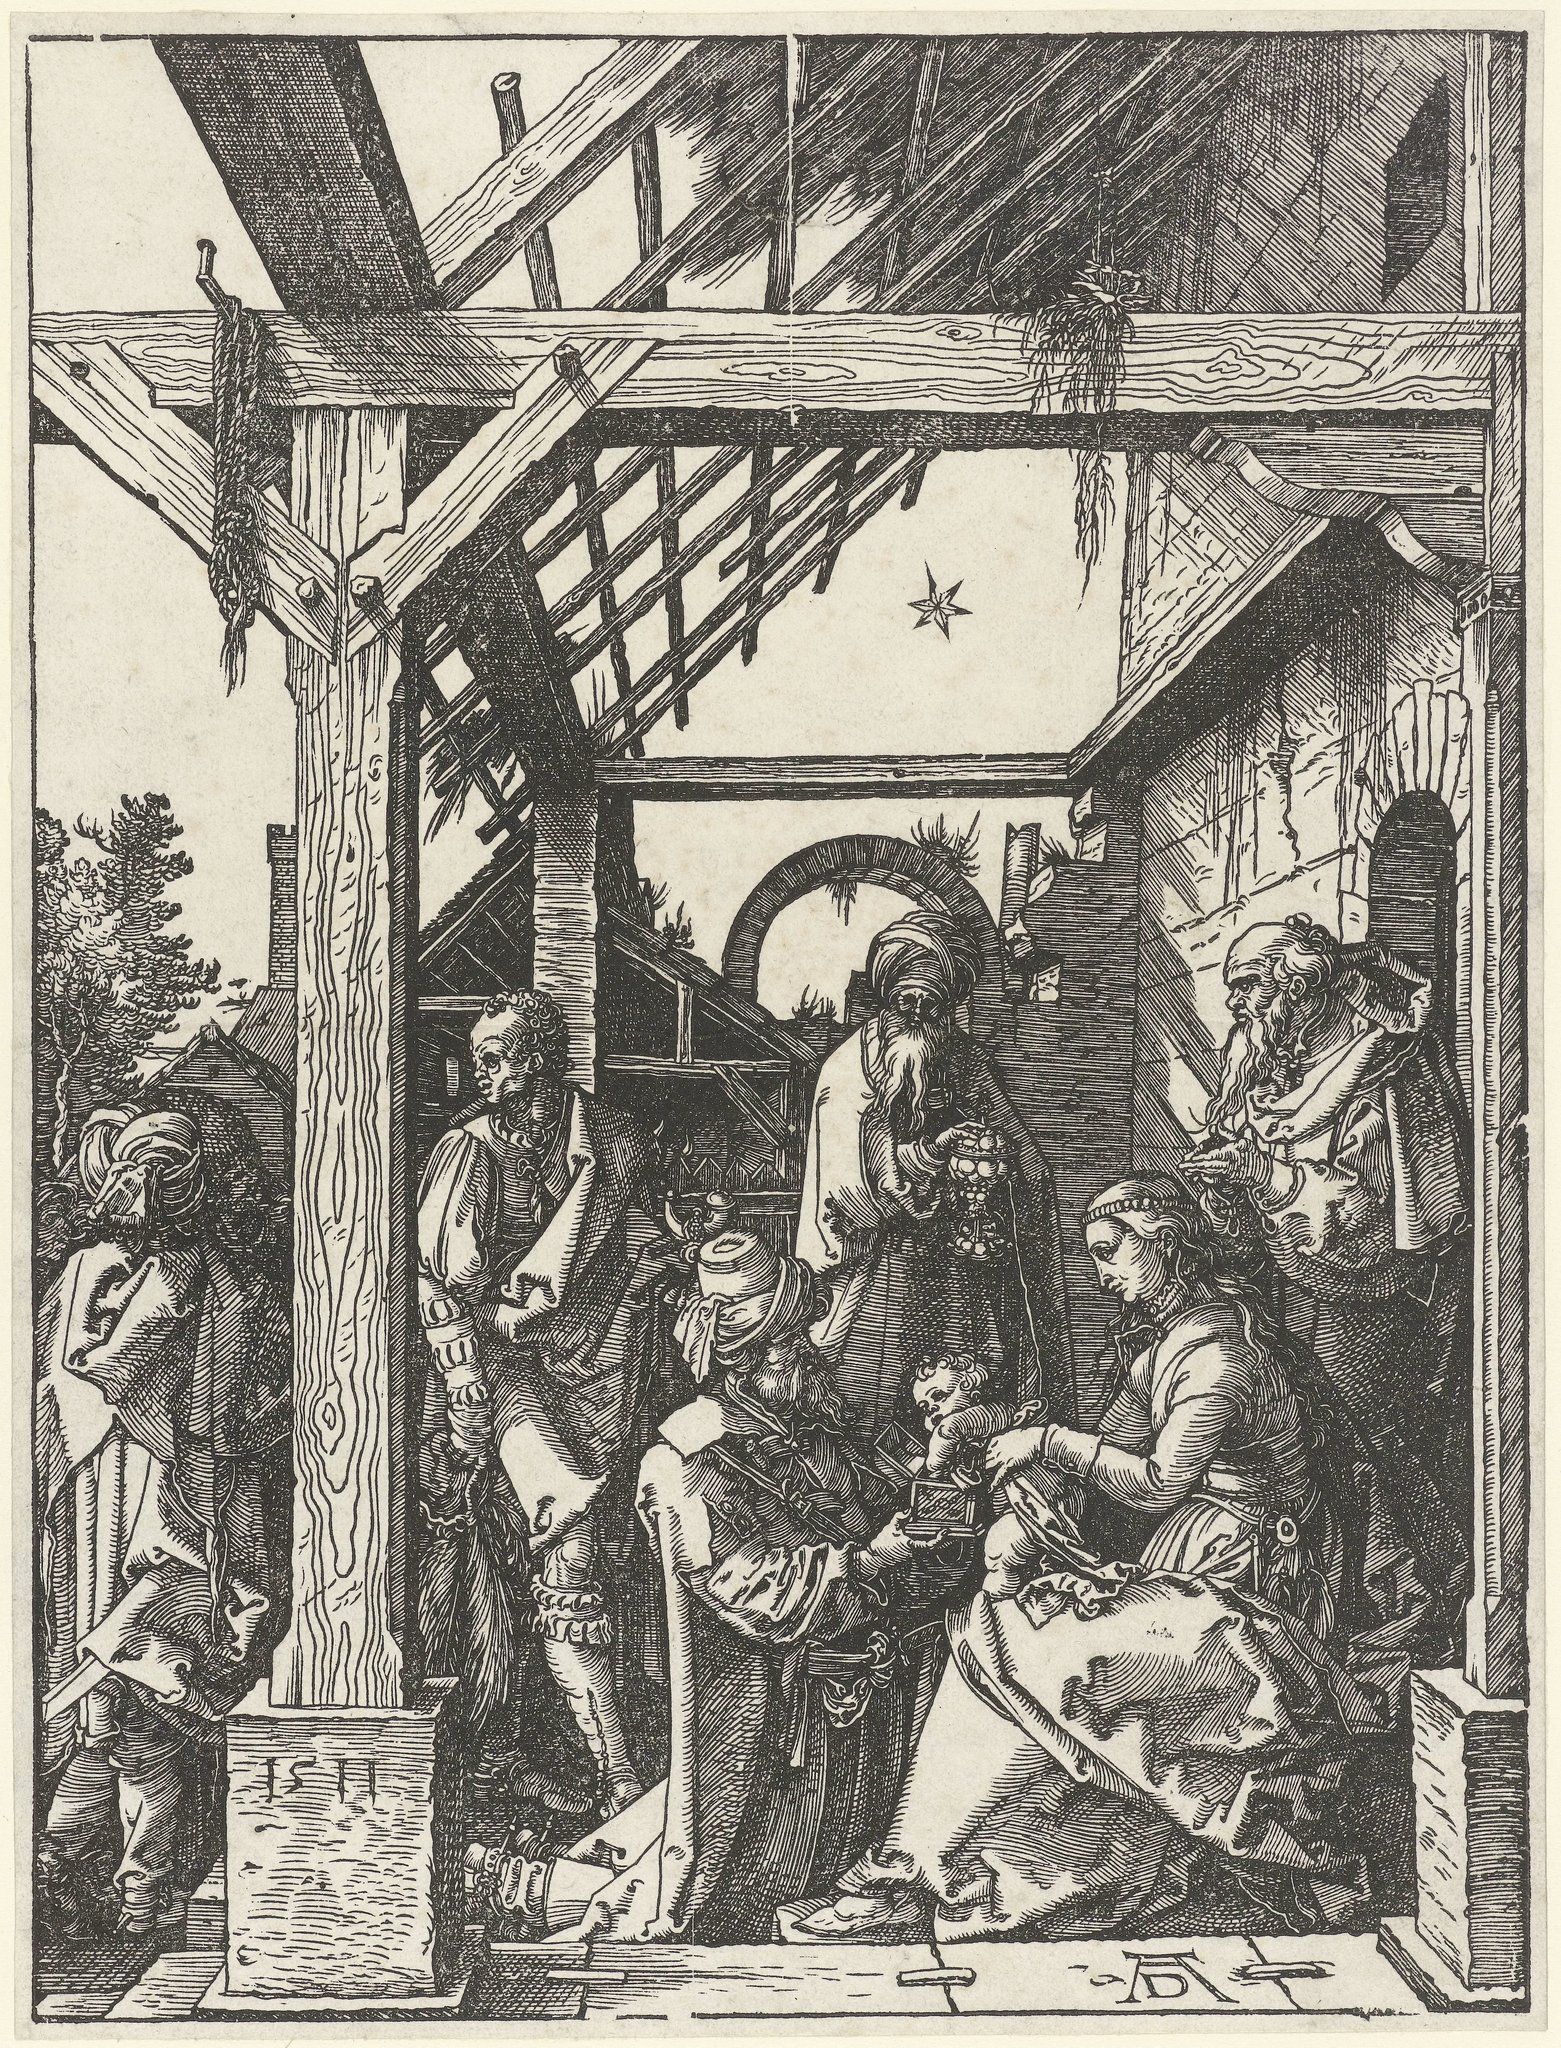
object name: print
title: De aanbidding door de koningen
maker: albrecht dürer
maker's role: draughtsman, painter, print maker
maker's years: 1471-1528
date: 1511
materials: paper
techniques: woodcut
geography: nuremberg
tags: adoration of the kings: the wise men present their gifts to the christ-child (gold, frankincense and myrrh)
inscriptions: inscription: ‘Geoffreerd aan de / Teken Akademie der stadt Amsterdam / 1788 P...’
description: De drie koningen of wijzen uit het Oosten bieden het Christuskind, gezeten op de schoot van zijn moeder in een vervallen woning, hun geschenken aan.